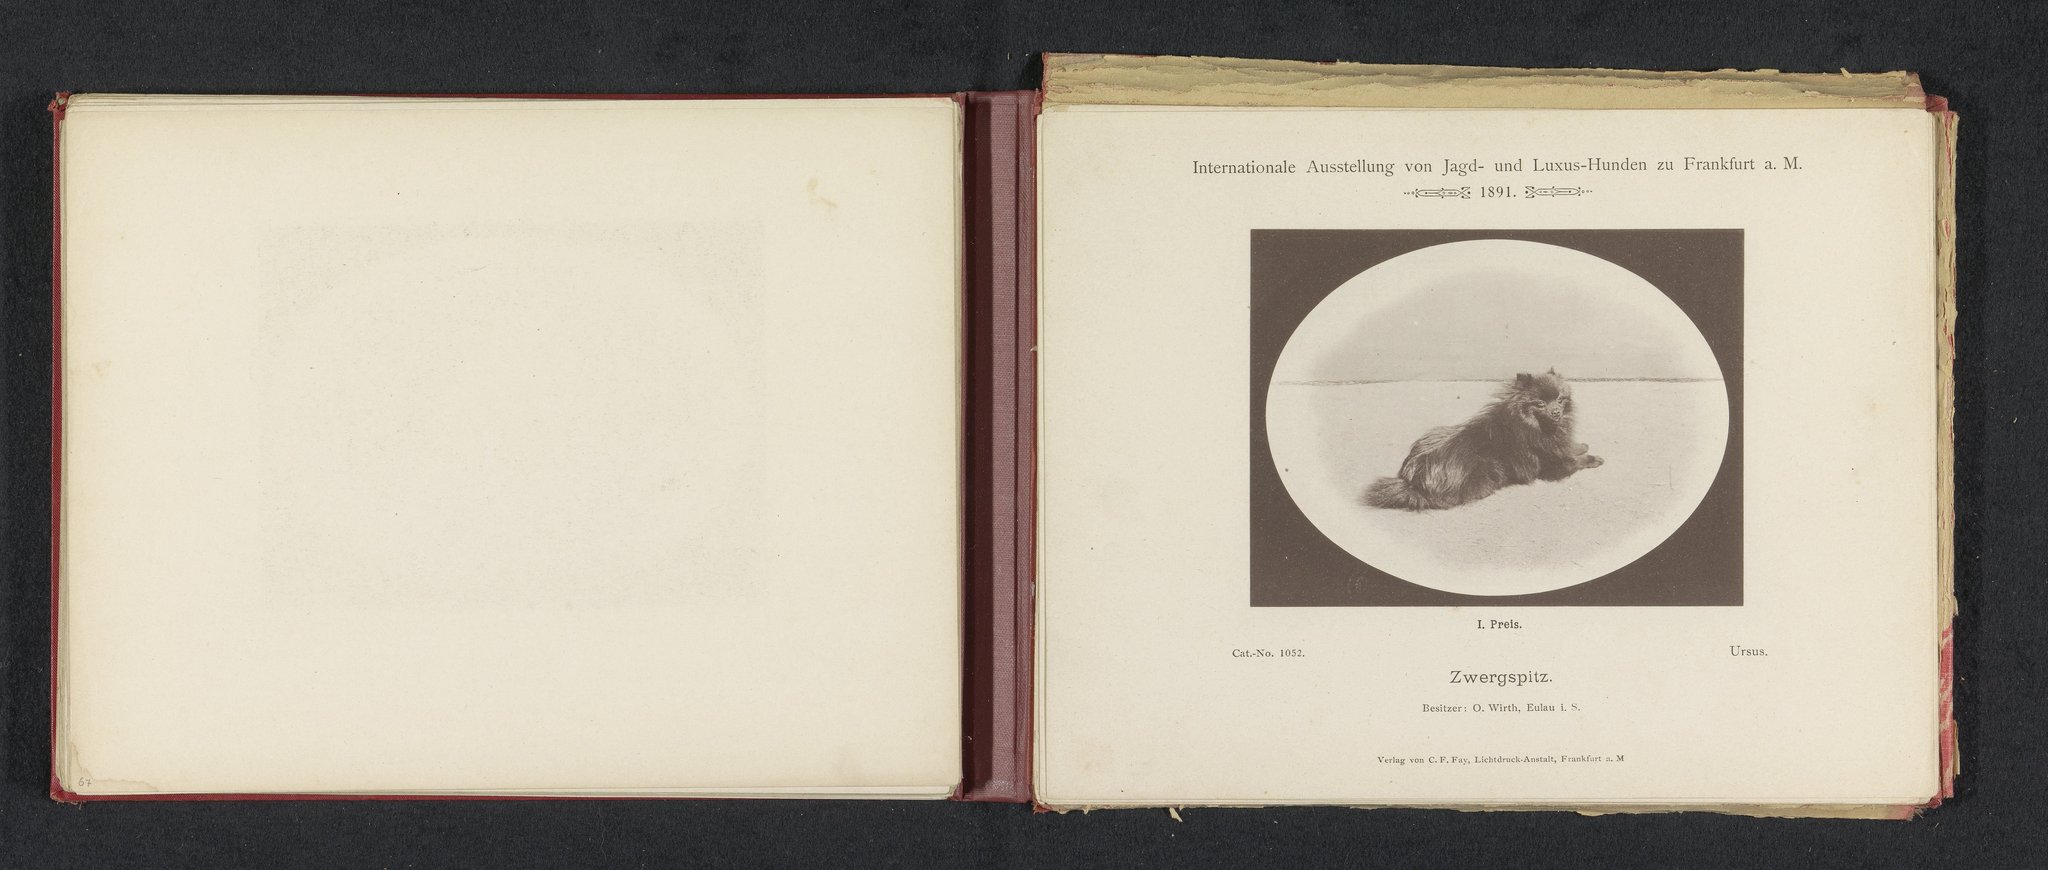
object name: page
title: Internationale Ausstellung von Jagd- und Luxus-Hunden zu Frankfurt a. M. 1891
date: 1891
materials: paper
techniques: photograph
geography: frankfurt am main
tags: dog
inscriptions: inscription: ‘I. Preis. Ursus. Besitzer : O. Wirth, Eulau i. S.’, number: ‘Cat.-No. 1052.’